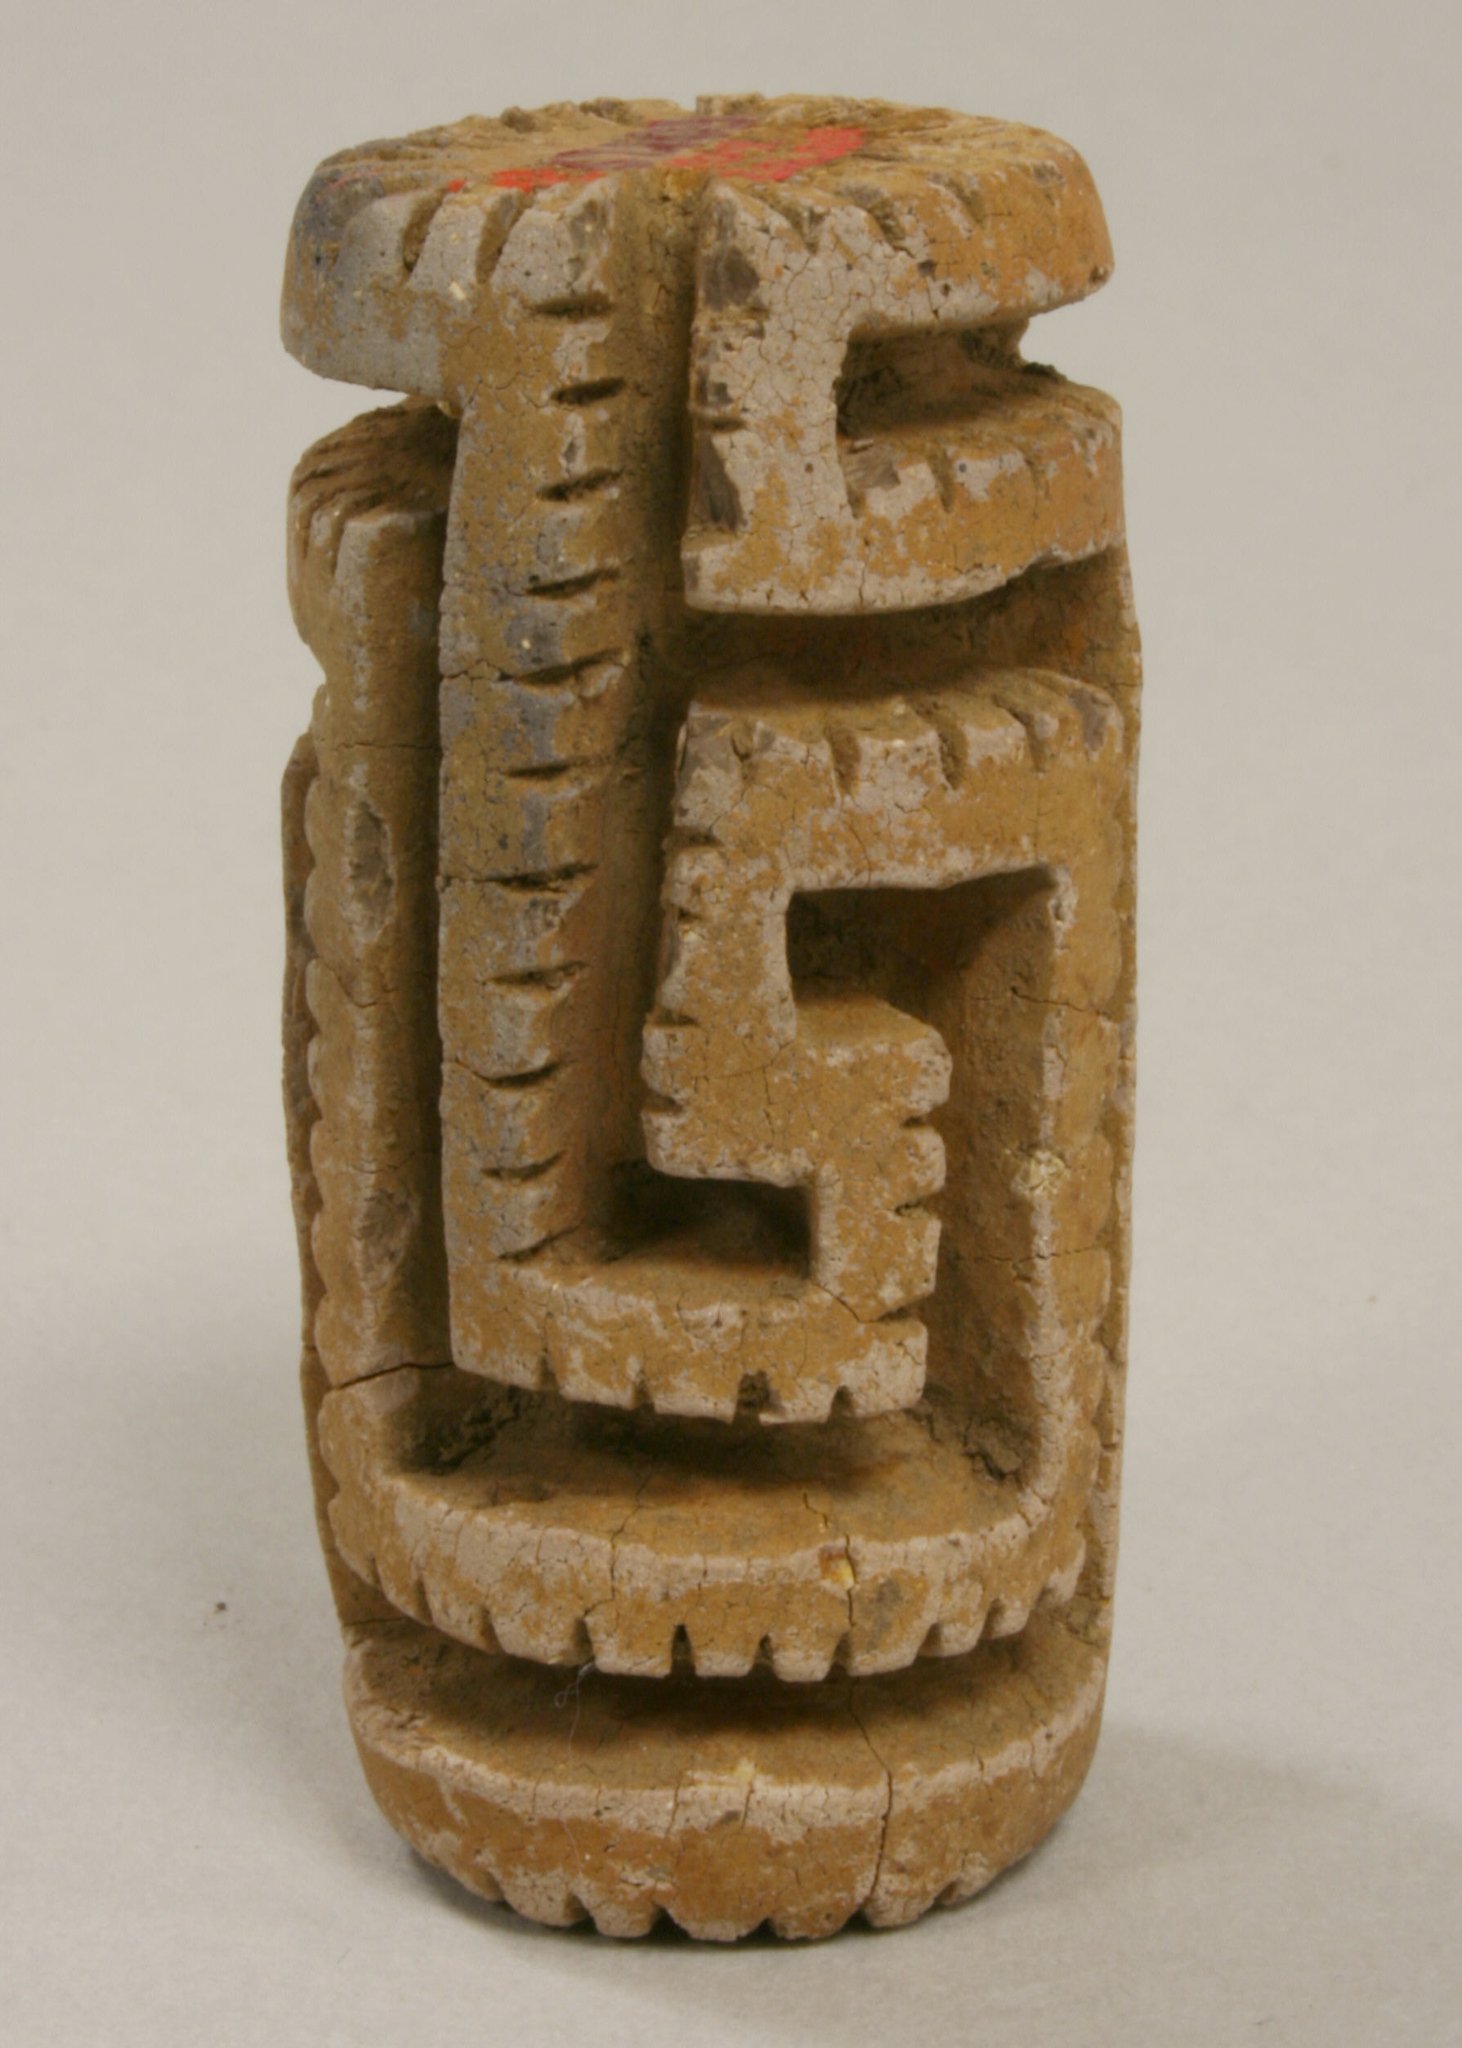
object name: stamp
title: Roller Stamp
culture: atlantic watershed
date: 401-600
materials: ceramic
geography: costa rica